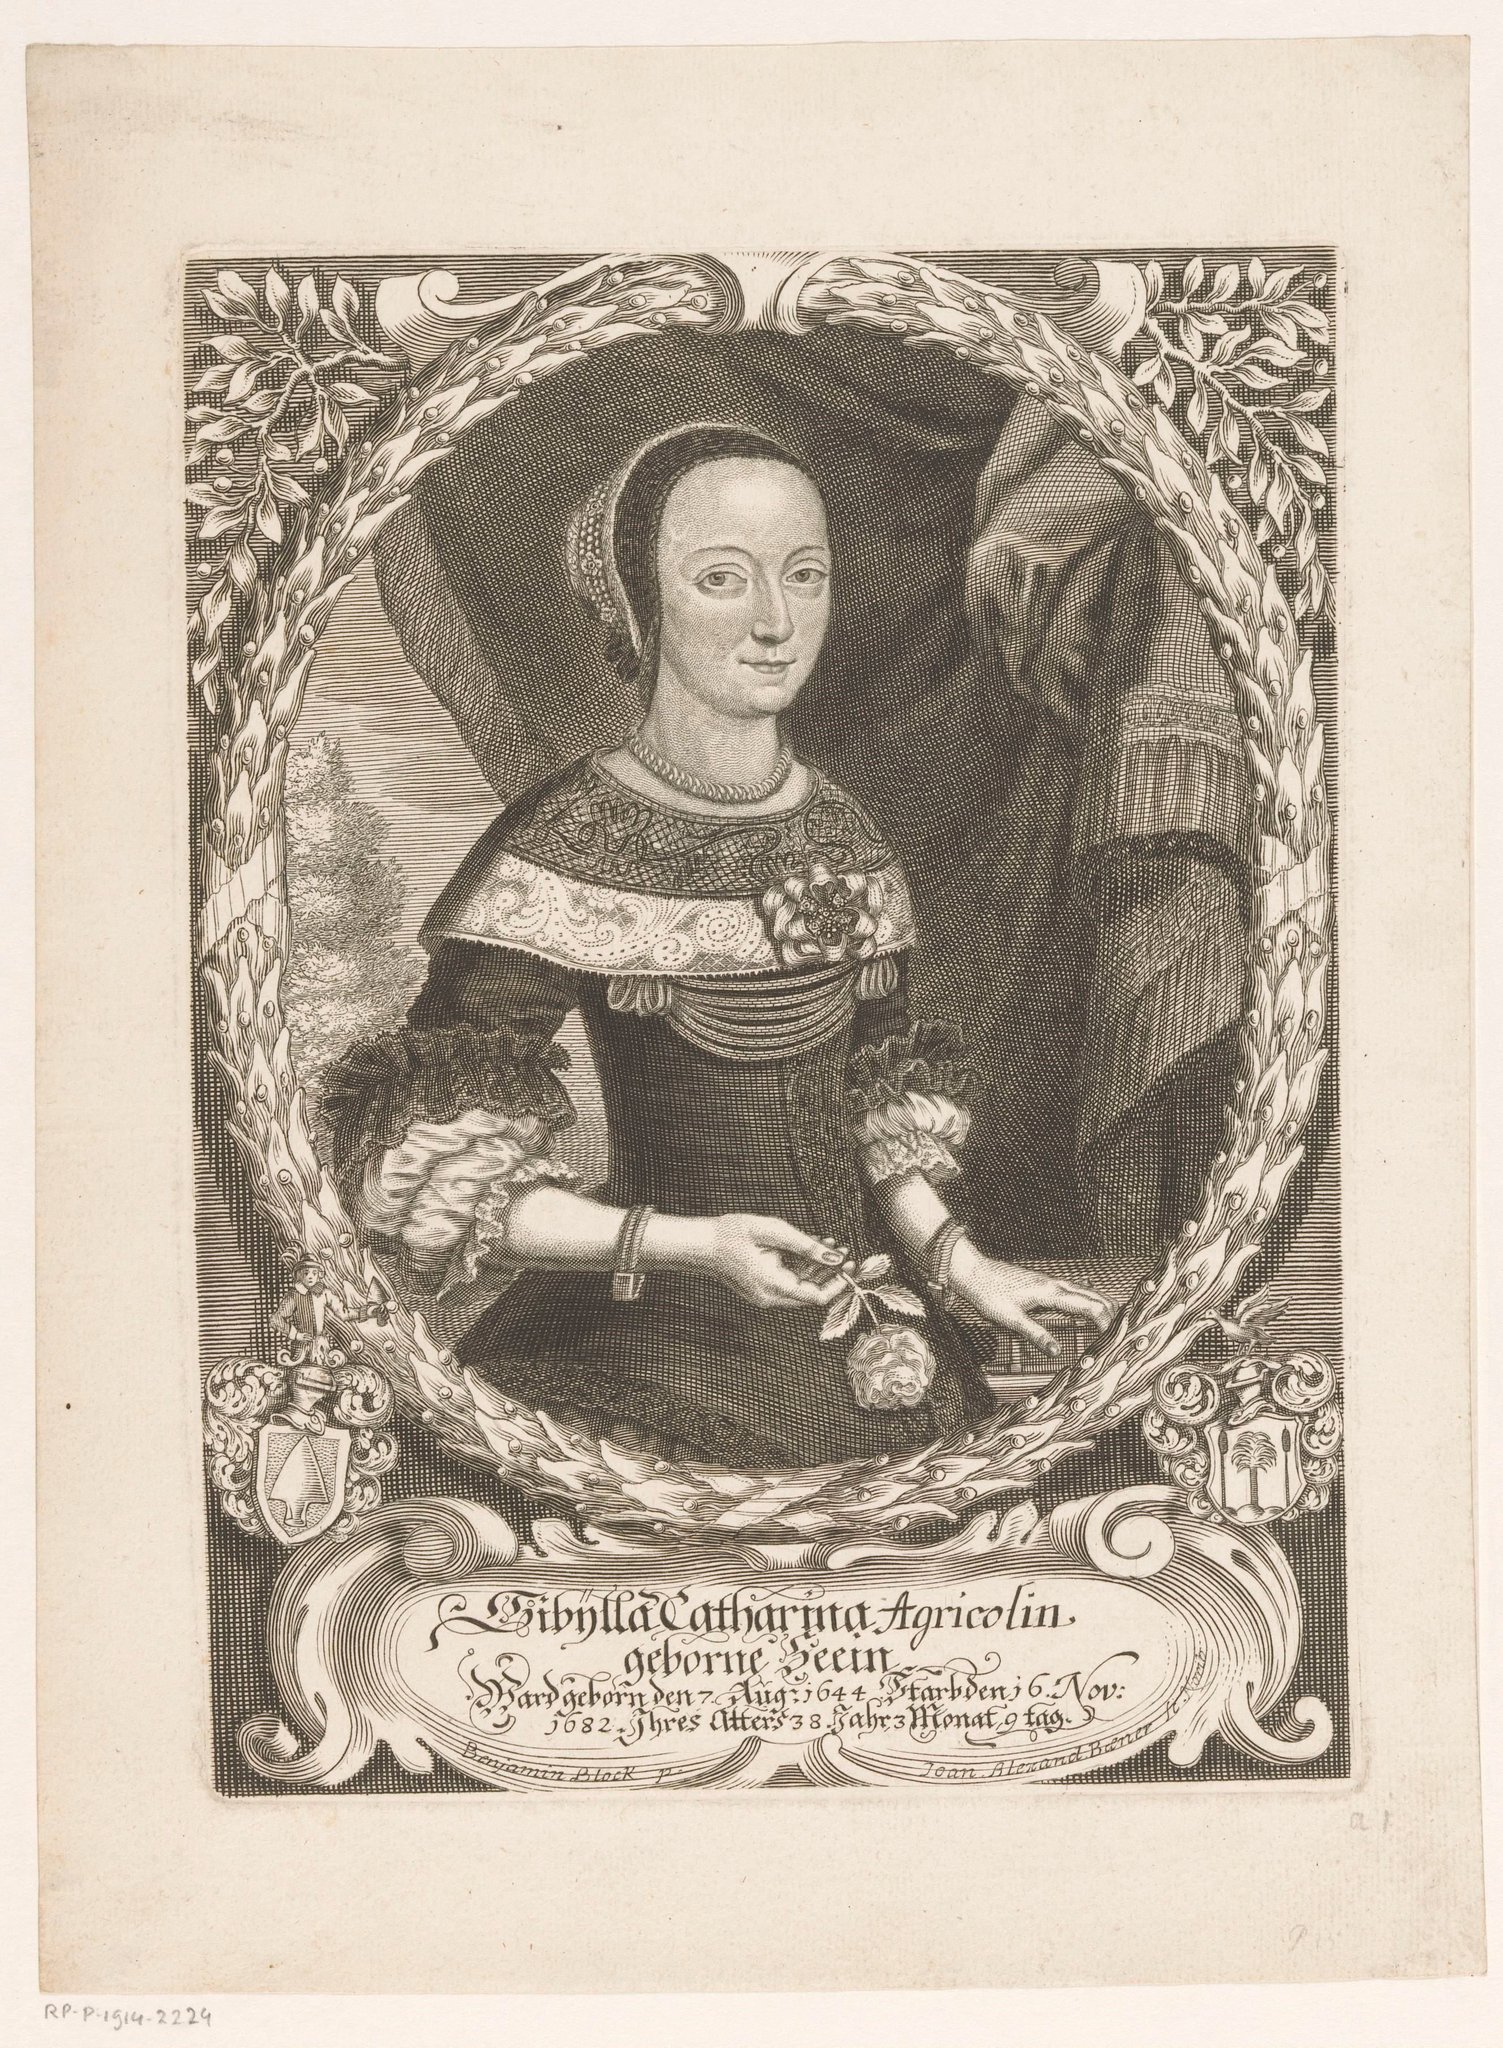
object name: print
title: Portret van Sibylla Catharina Agricola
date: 1682-1720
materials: paper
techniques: engraving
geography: nuremberg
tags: historical persons - bb - woman, book, flowers: rose, armorial bearing, heraldry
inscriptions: collector's mark: Lugt 2228